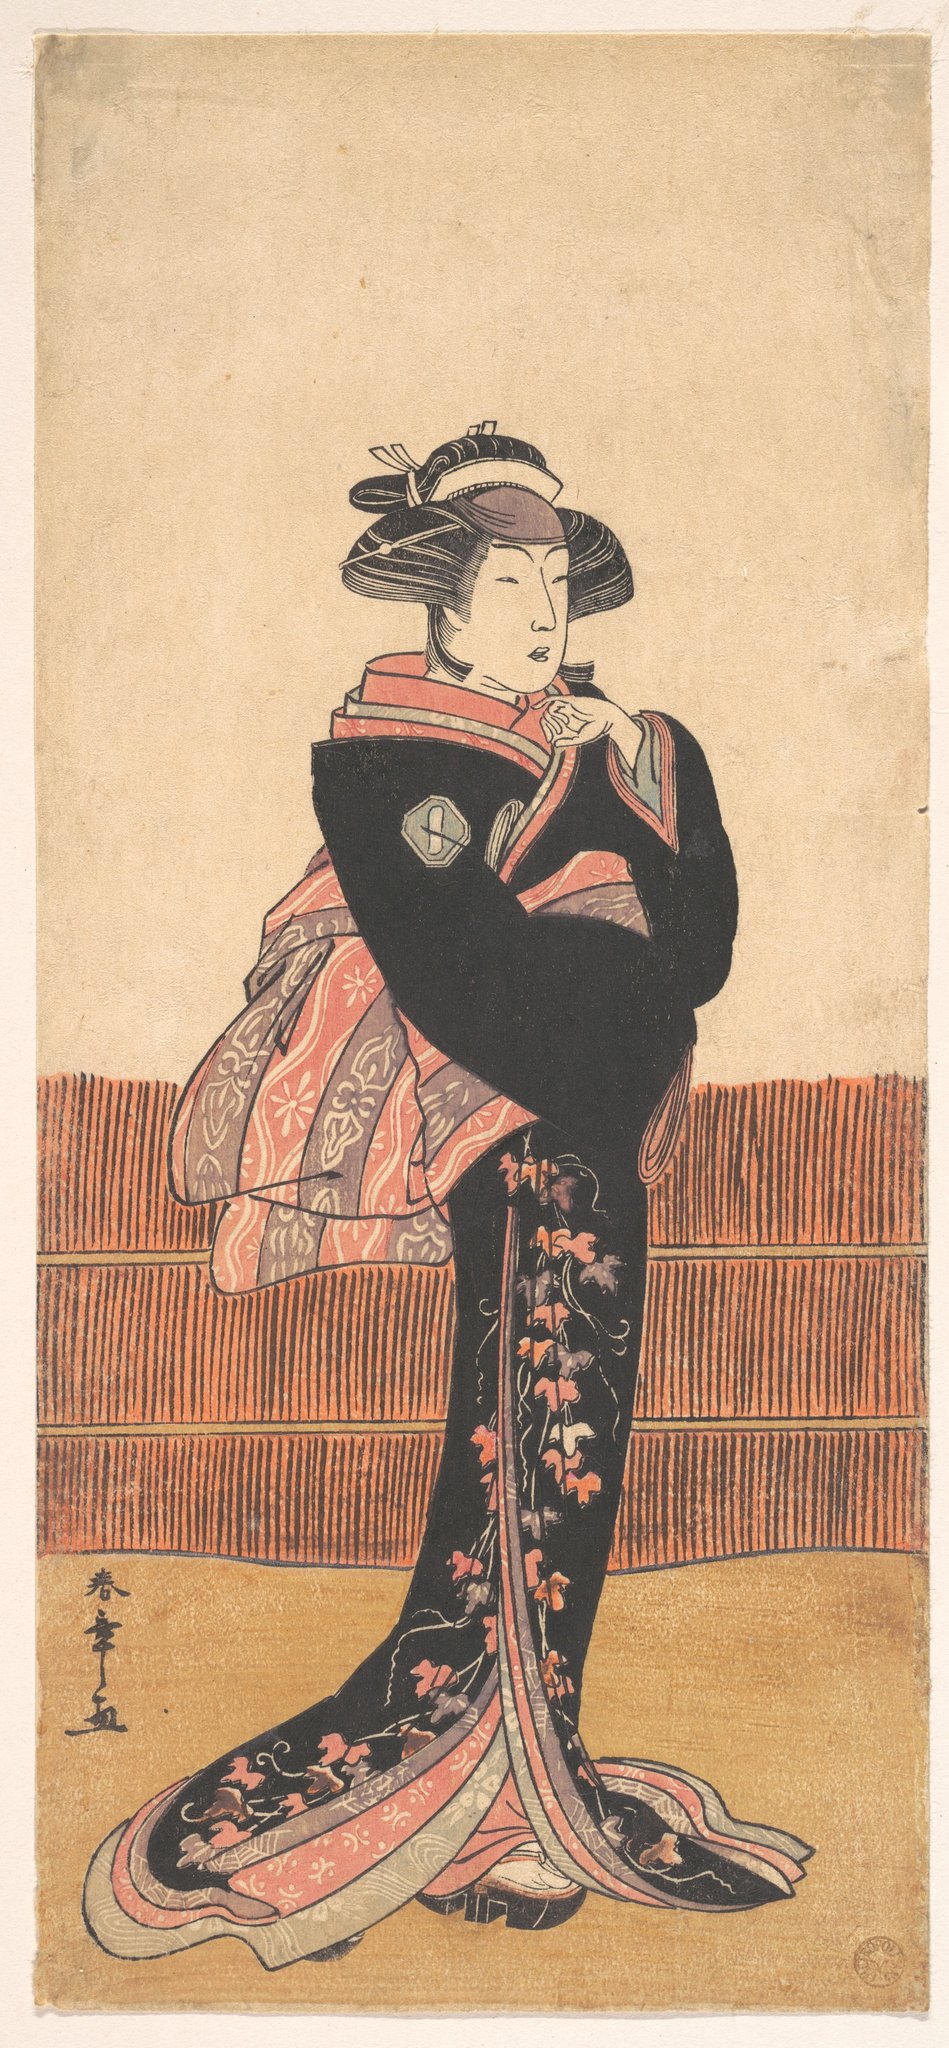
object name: woodblock print nishiki e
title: Kabuki Actor Azuma Tōzō III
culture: japanese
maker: katsukawa shunshō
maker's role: artist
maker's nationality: japanese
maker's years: 1726-1792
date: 1782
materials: ink, paper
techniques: nishiki e, woodblock print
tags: actors